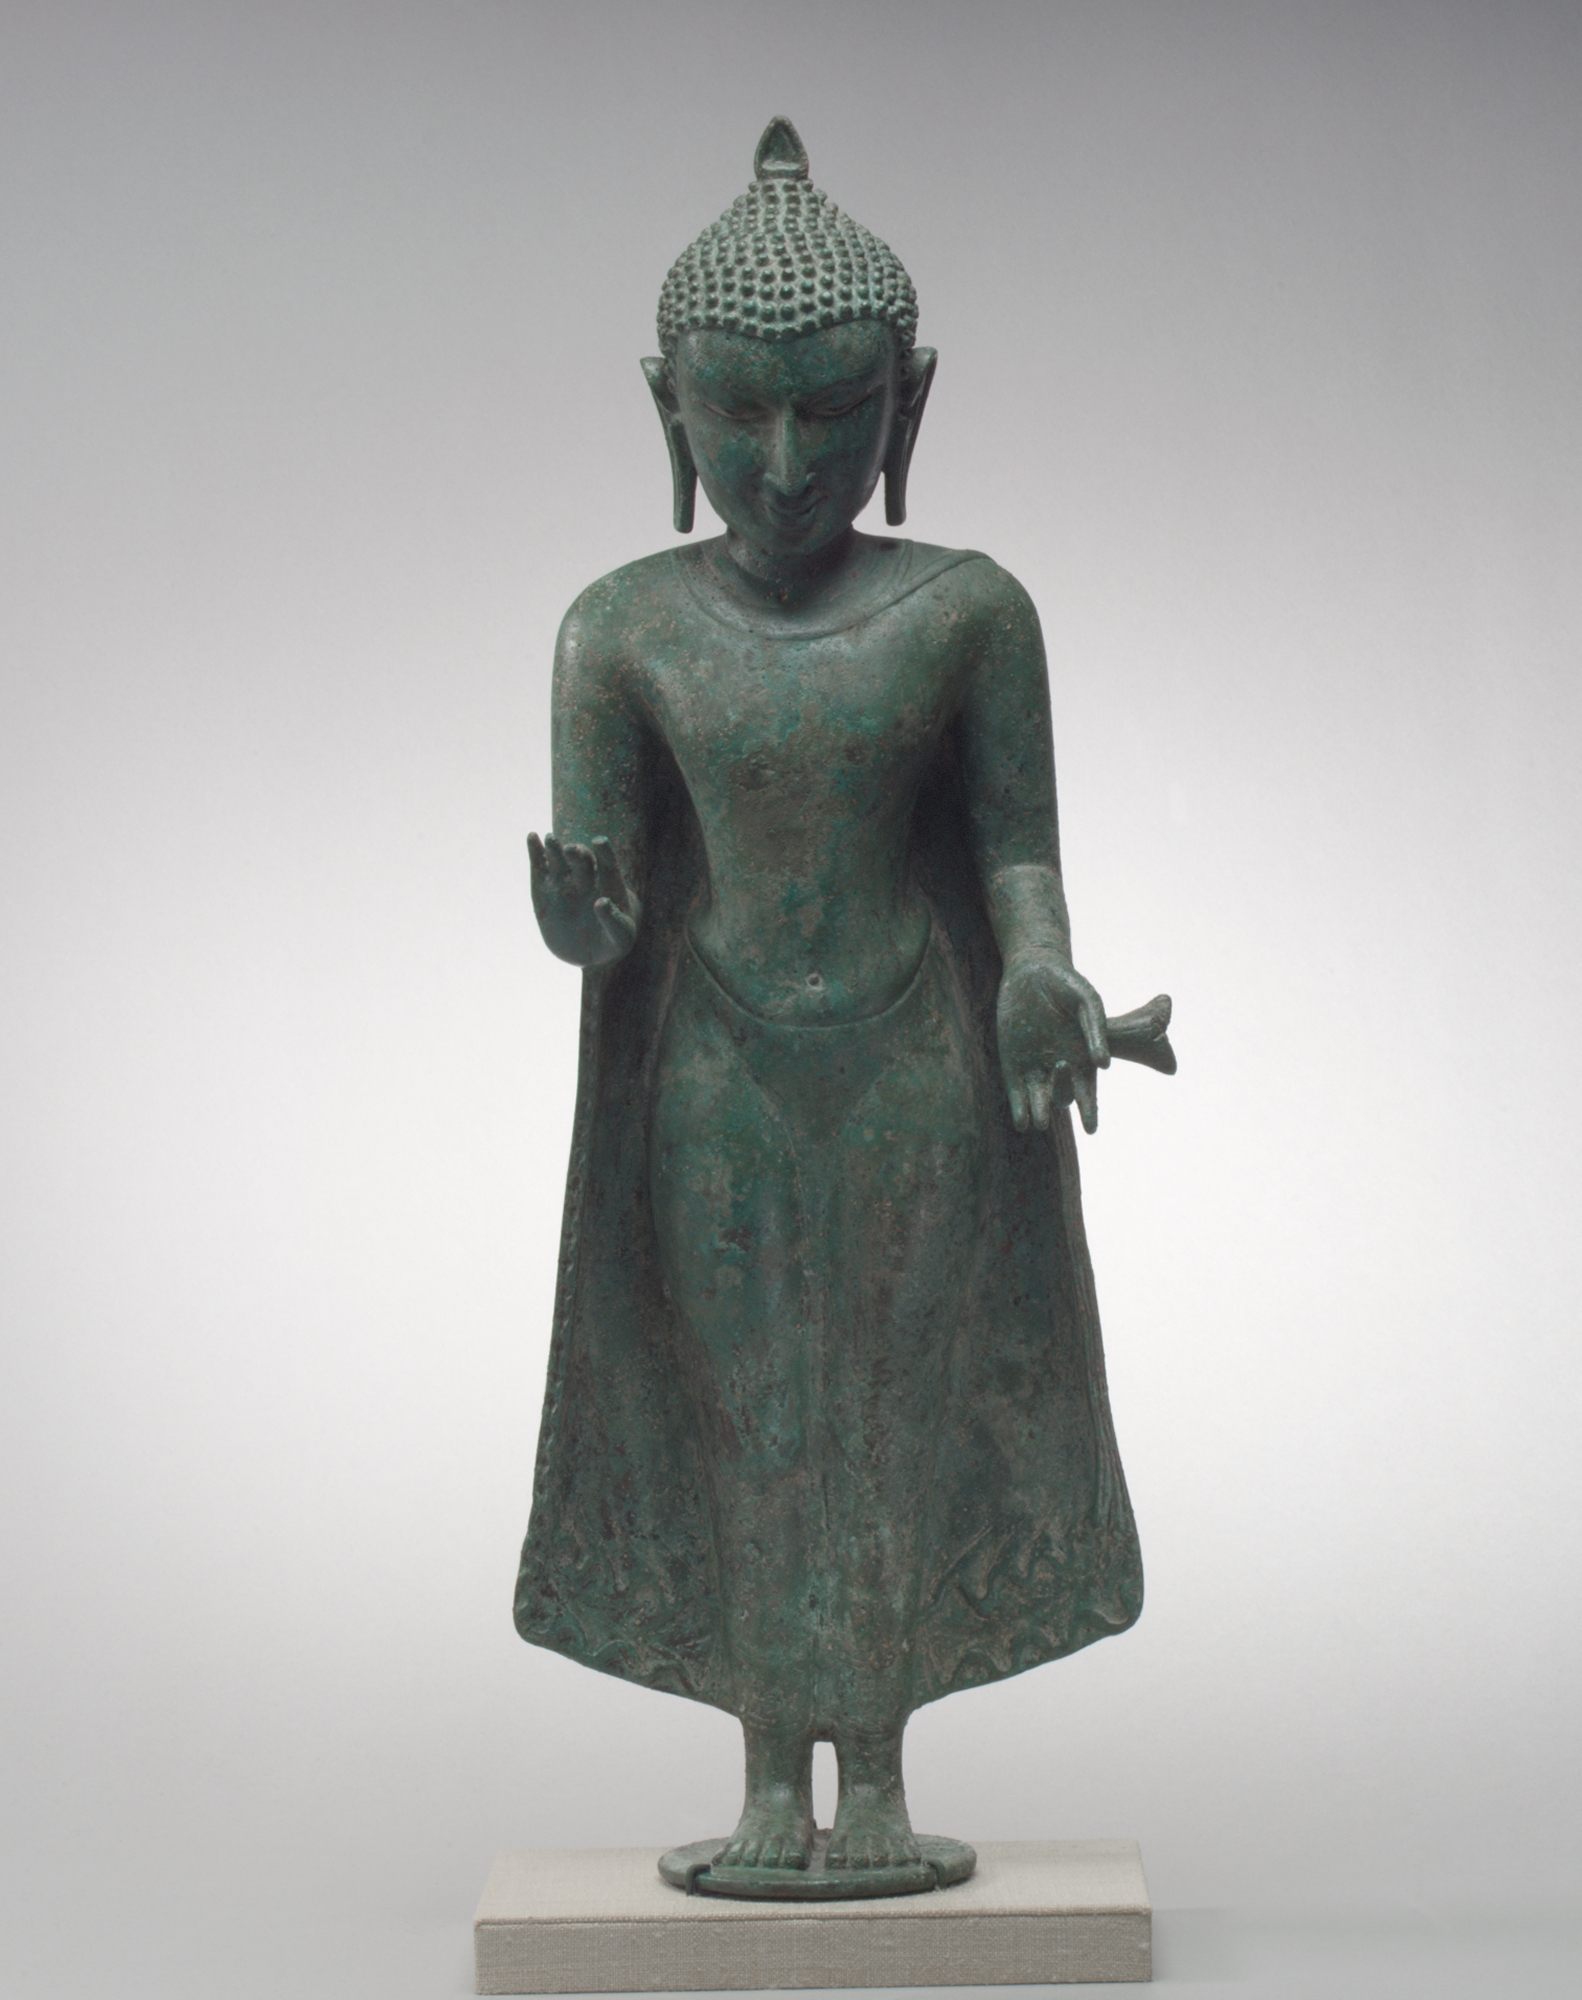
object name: figure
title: Standing Buddha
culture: burmese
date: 1101-1300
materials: bronze, silver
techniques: inlay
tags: buddhism,buddha